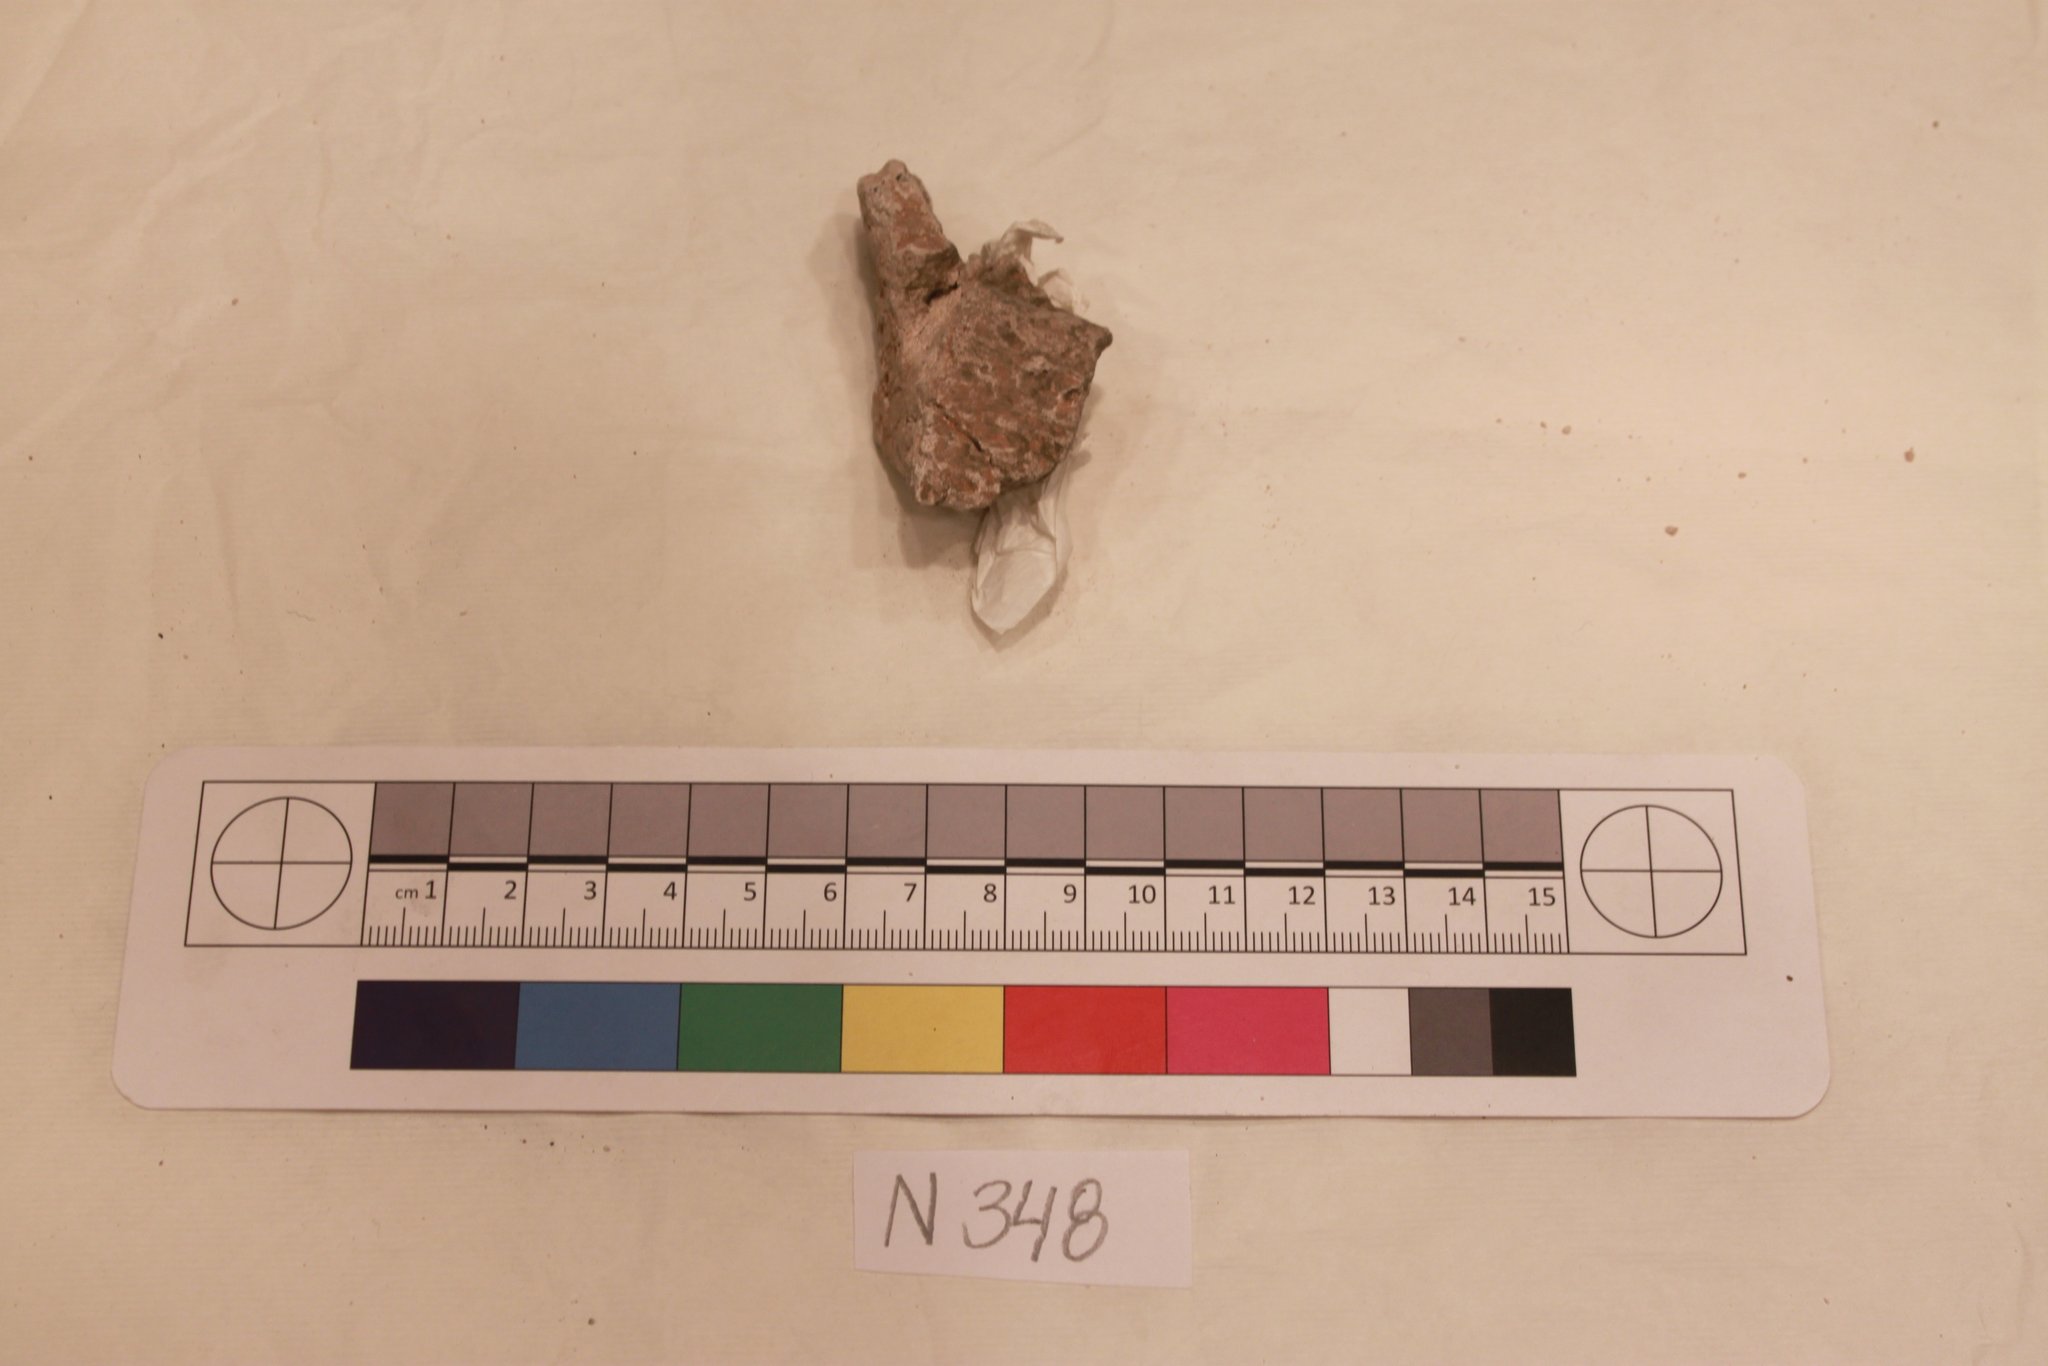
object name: fragment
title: Stucco Fragment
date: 701-1200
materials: plaster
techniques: carving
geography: iran